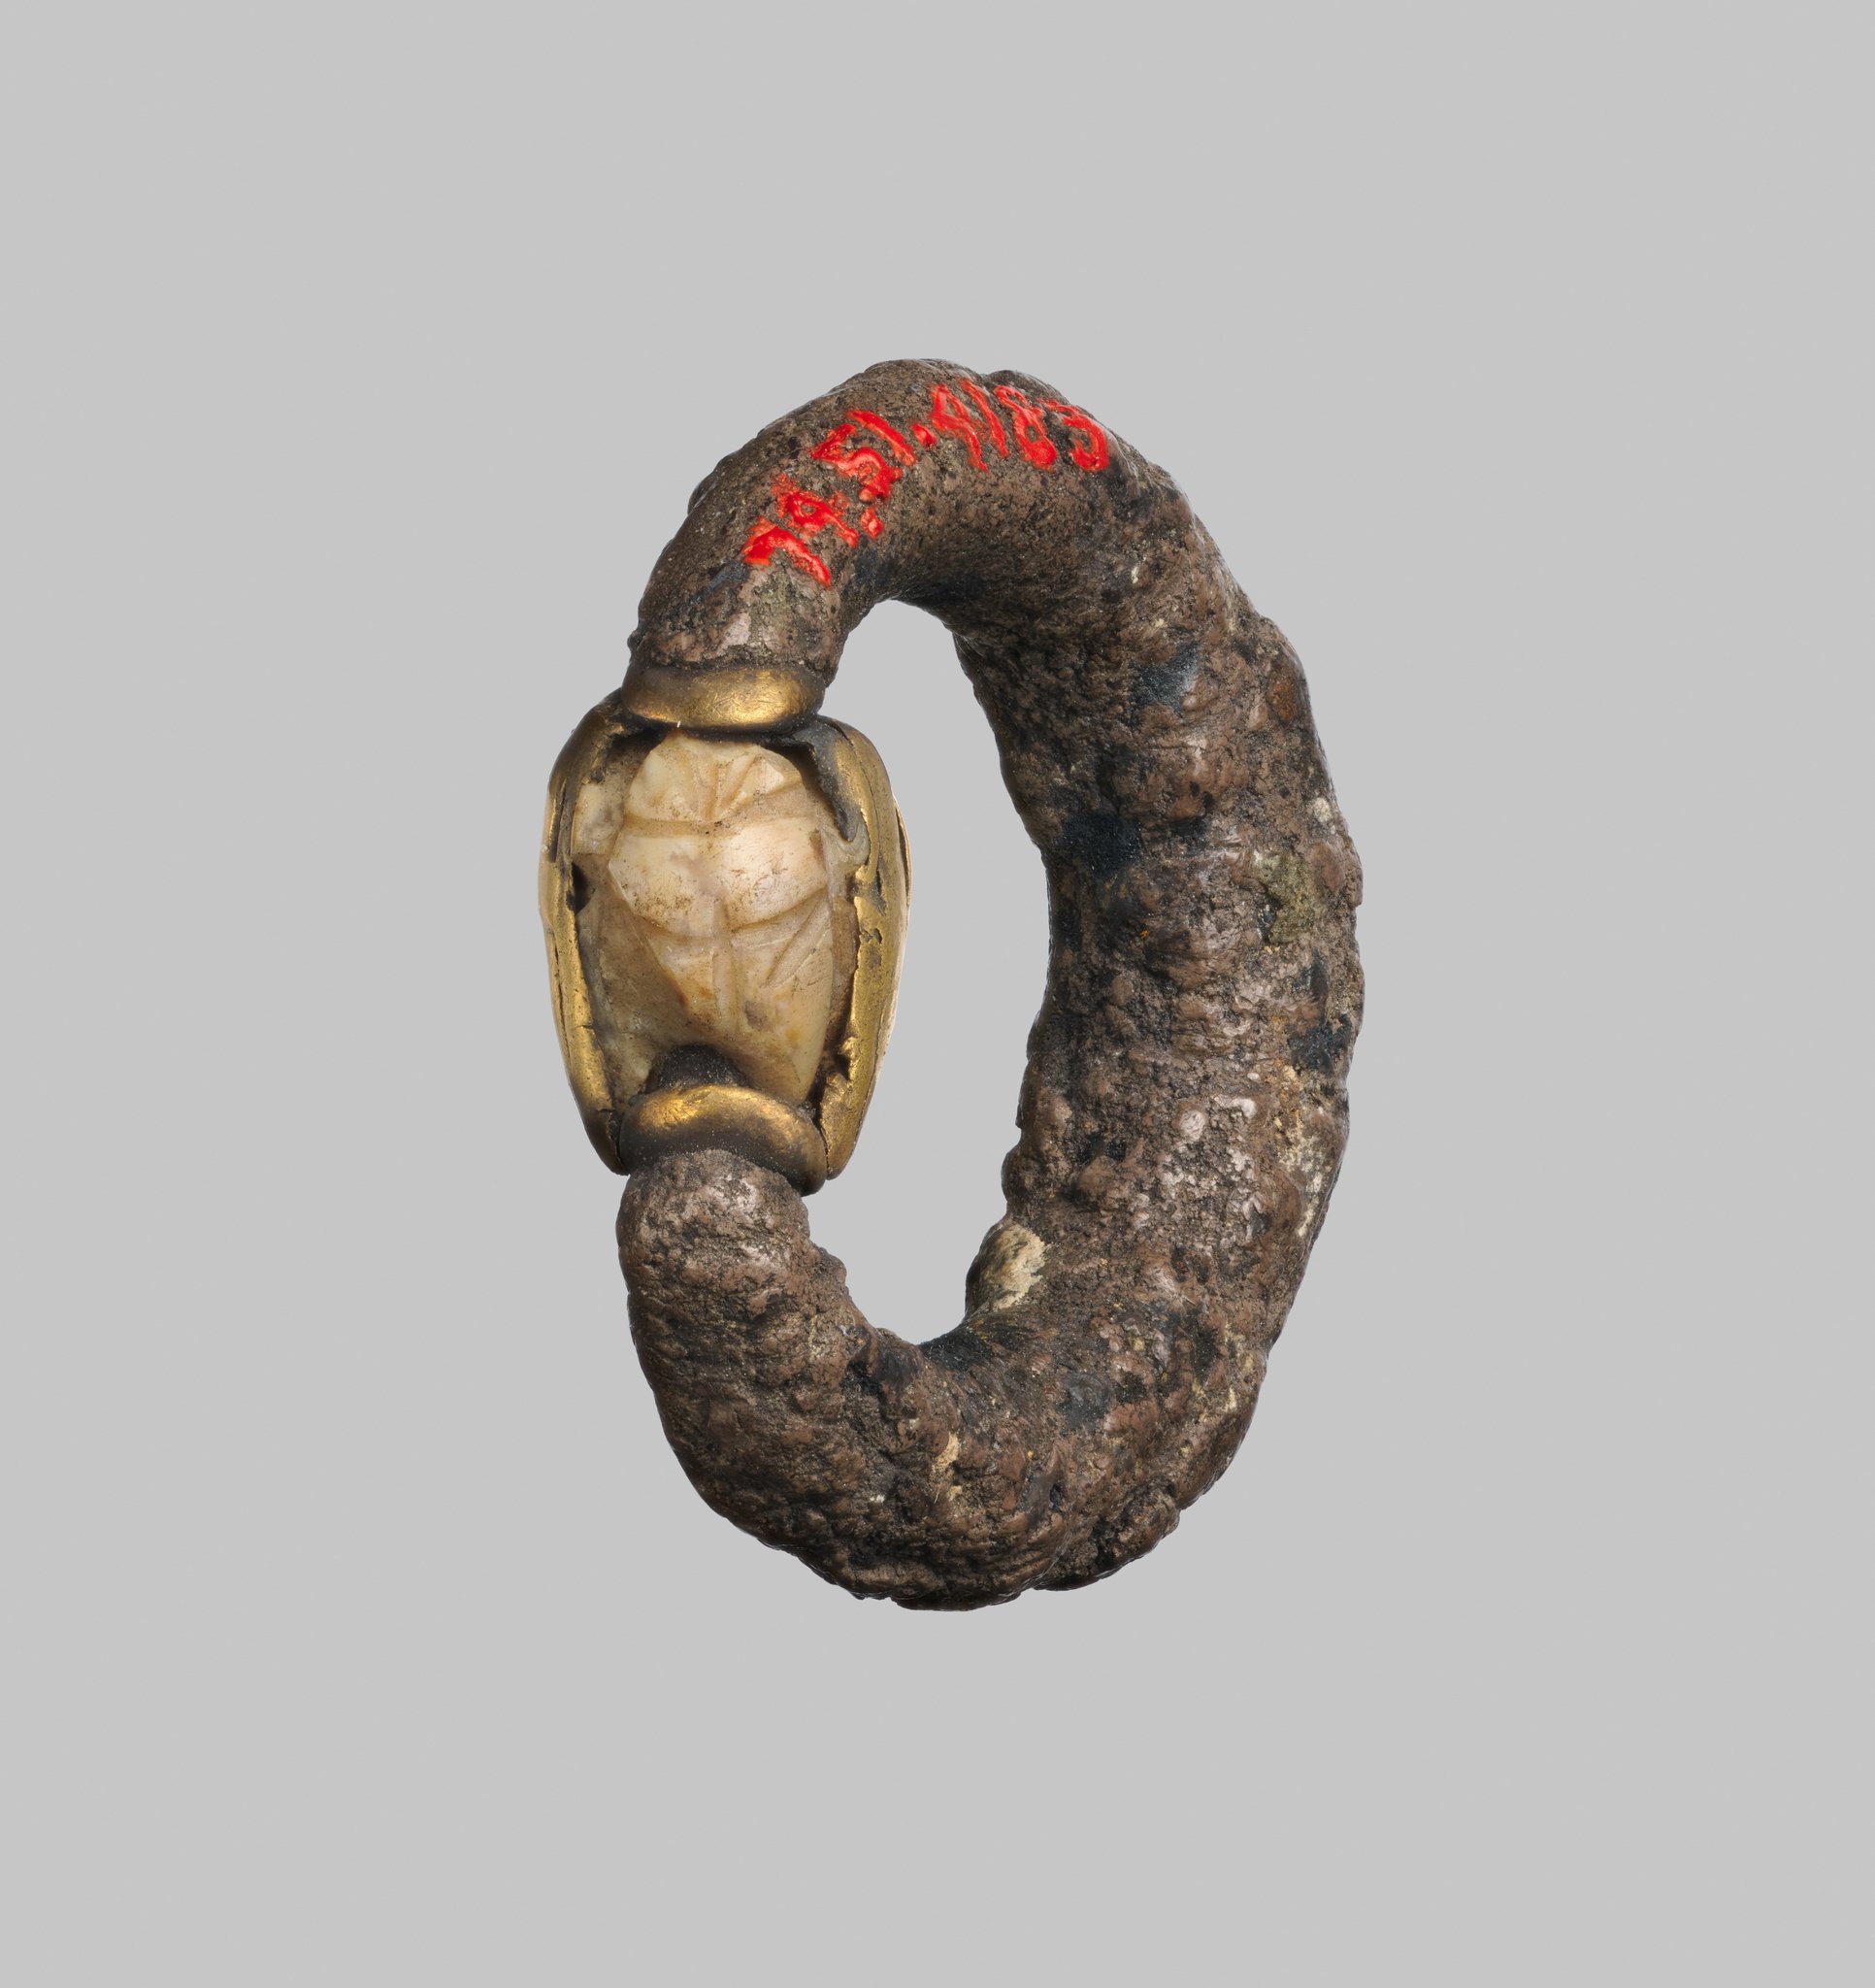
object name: ring with a scarab inscribed with an ankh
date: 1070-712 BCE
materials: gold, silver, stone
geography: levant